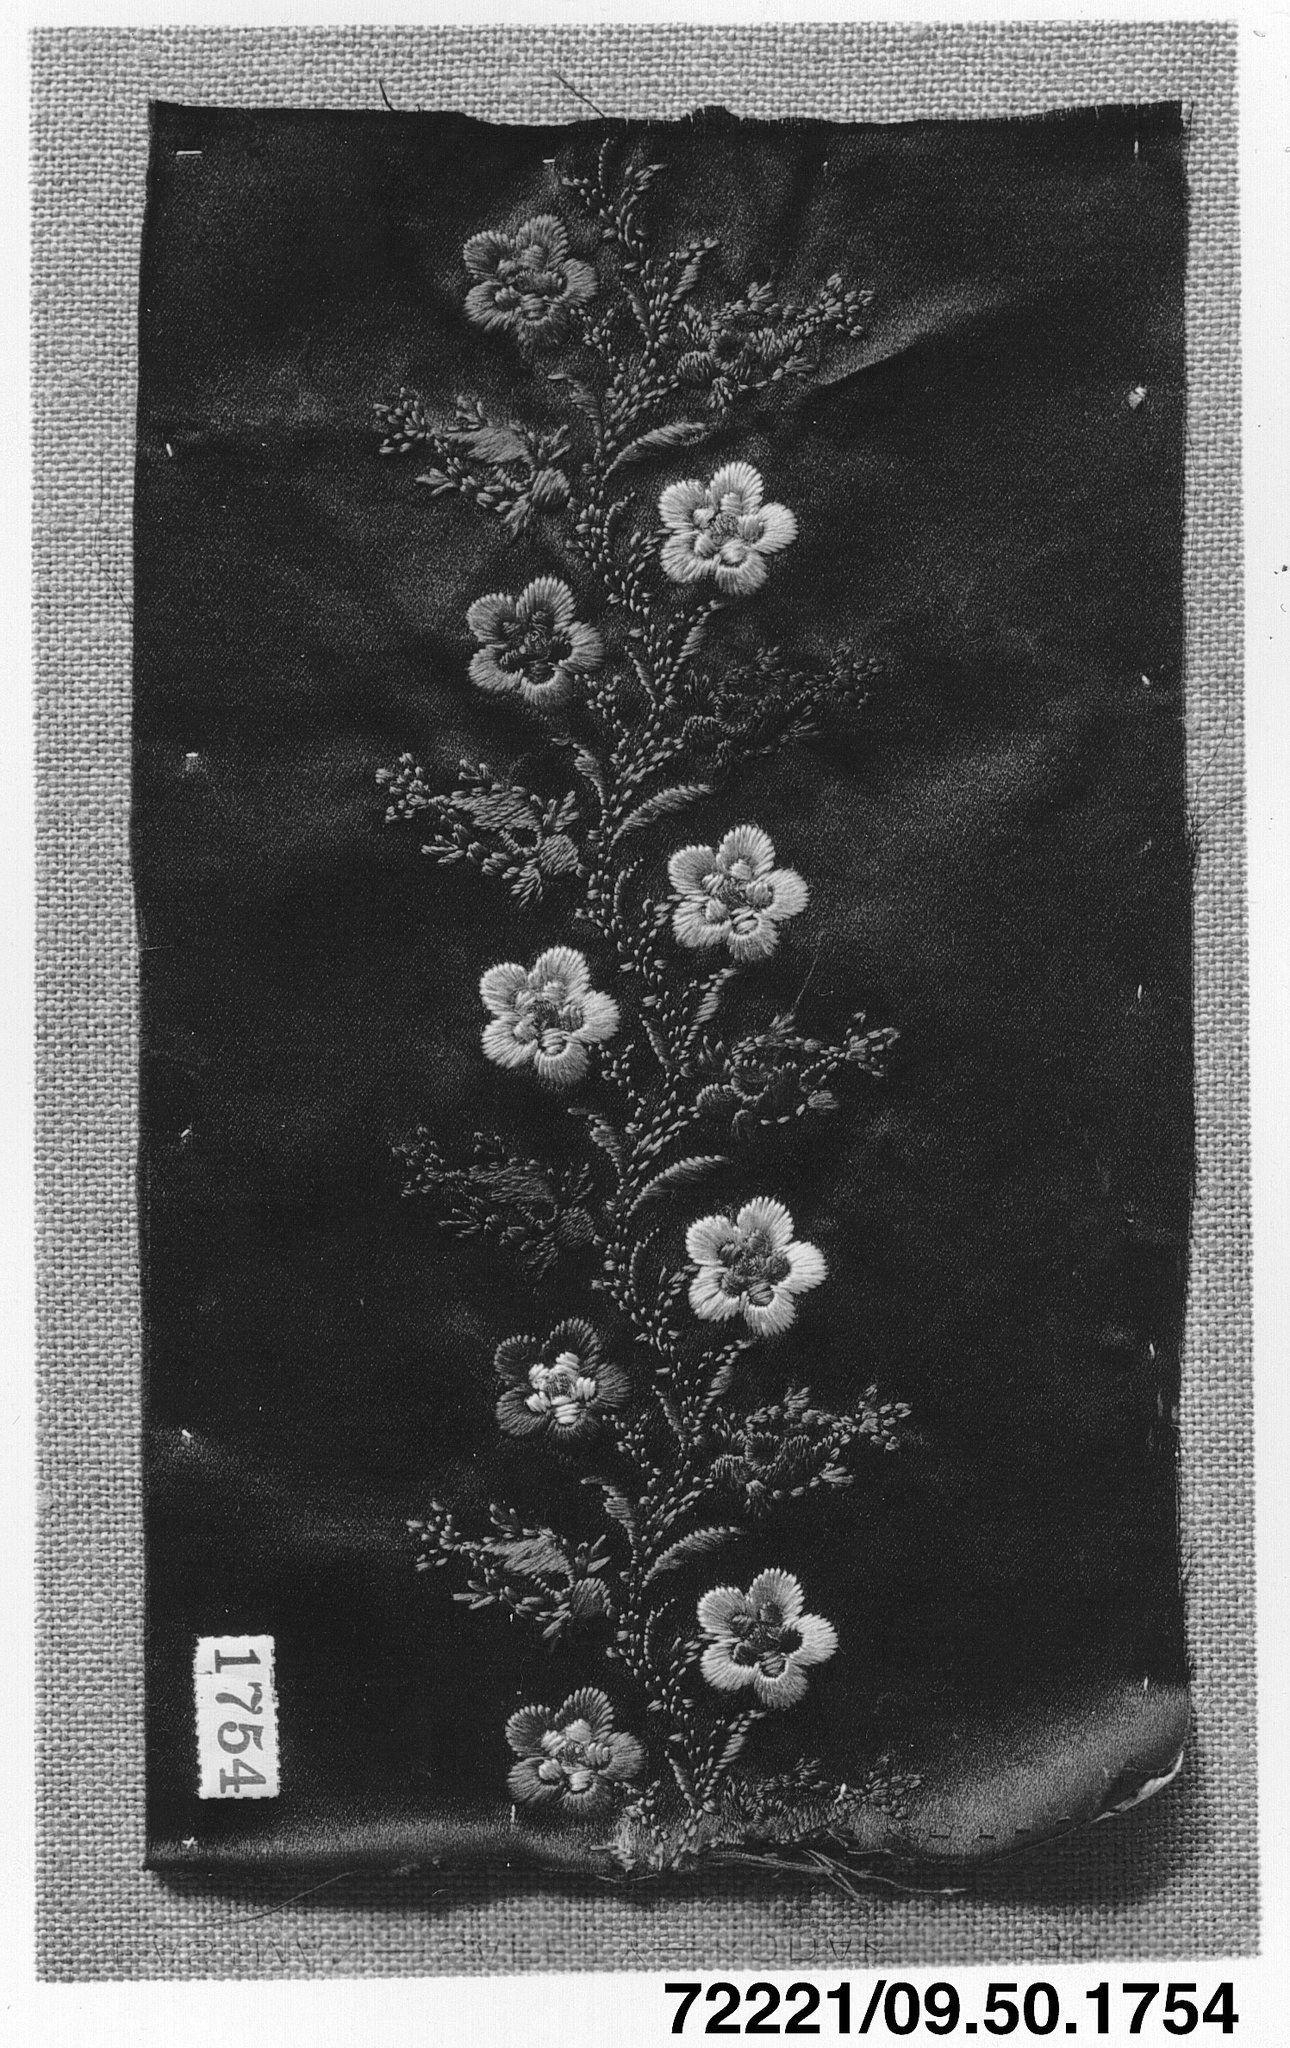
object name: fragment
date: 1801-1900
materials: silk